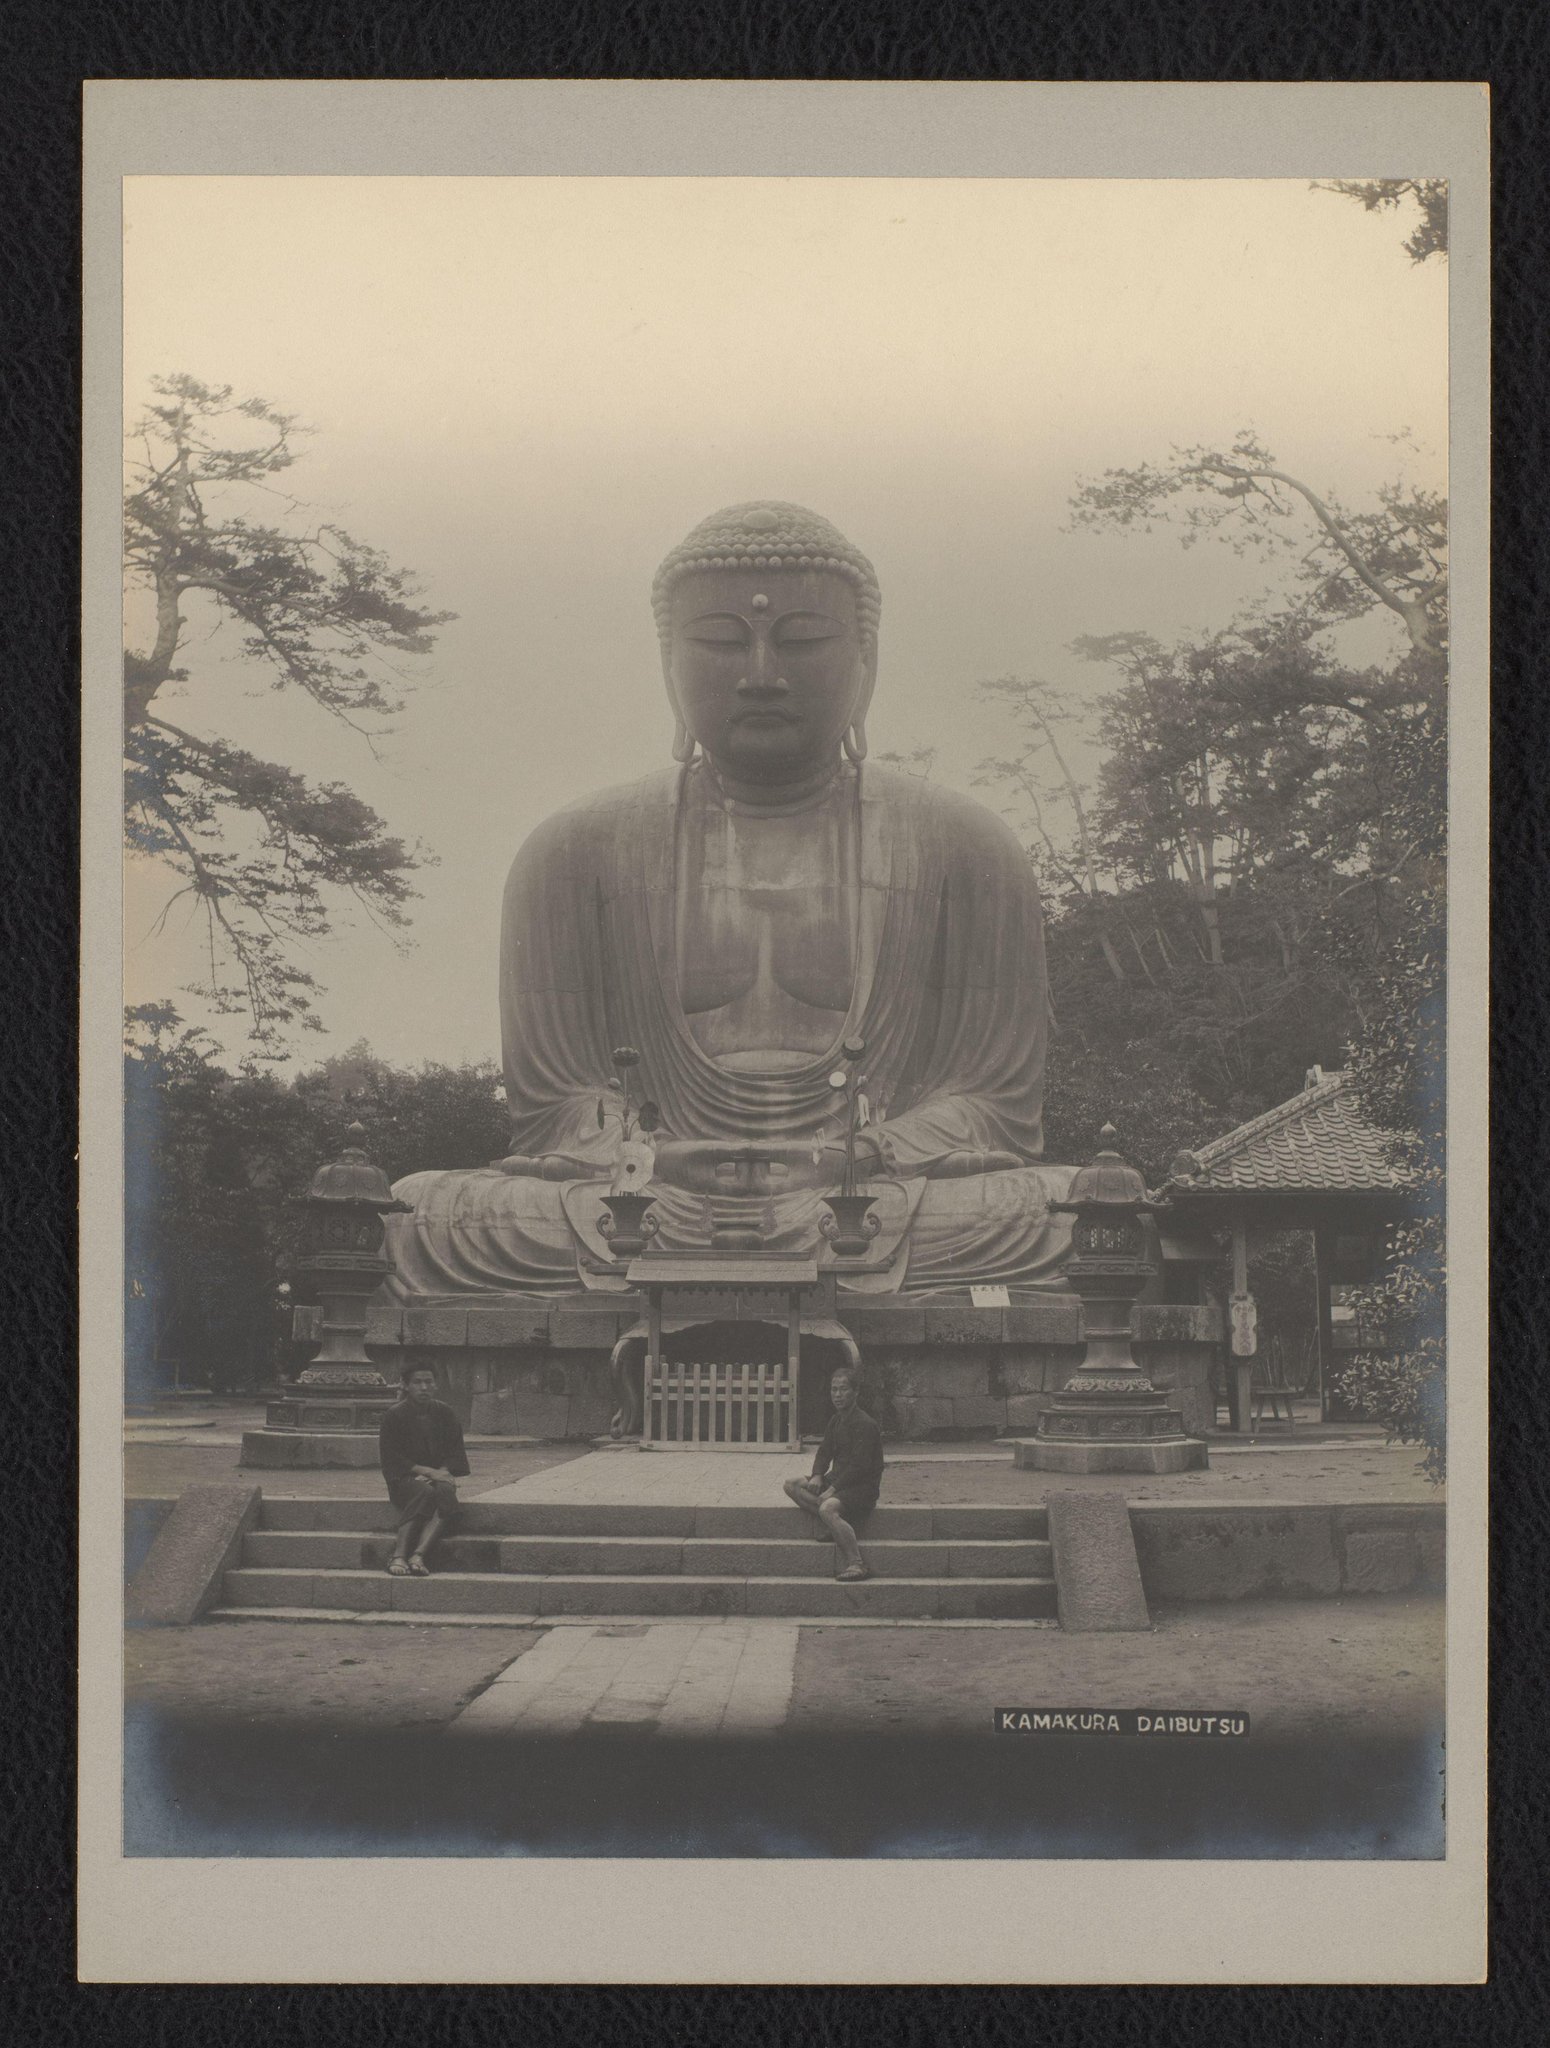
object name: photograph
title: Grote Buddha, Kamakura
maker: Anonymous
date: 1895-1915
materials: cardboard, photographic support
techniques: gelatin silver print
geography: kamakura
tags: kamakura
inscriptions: number: ‘26.’